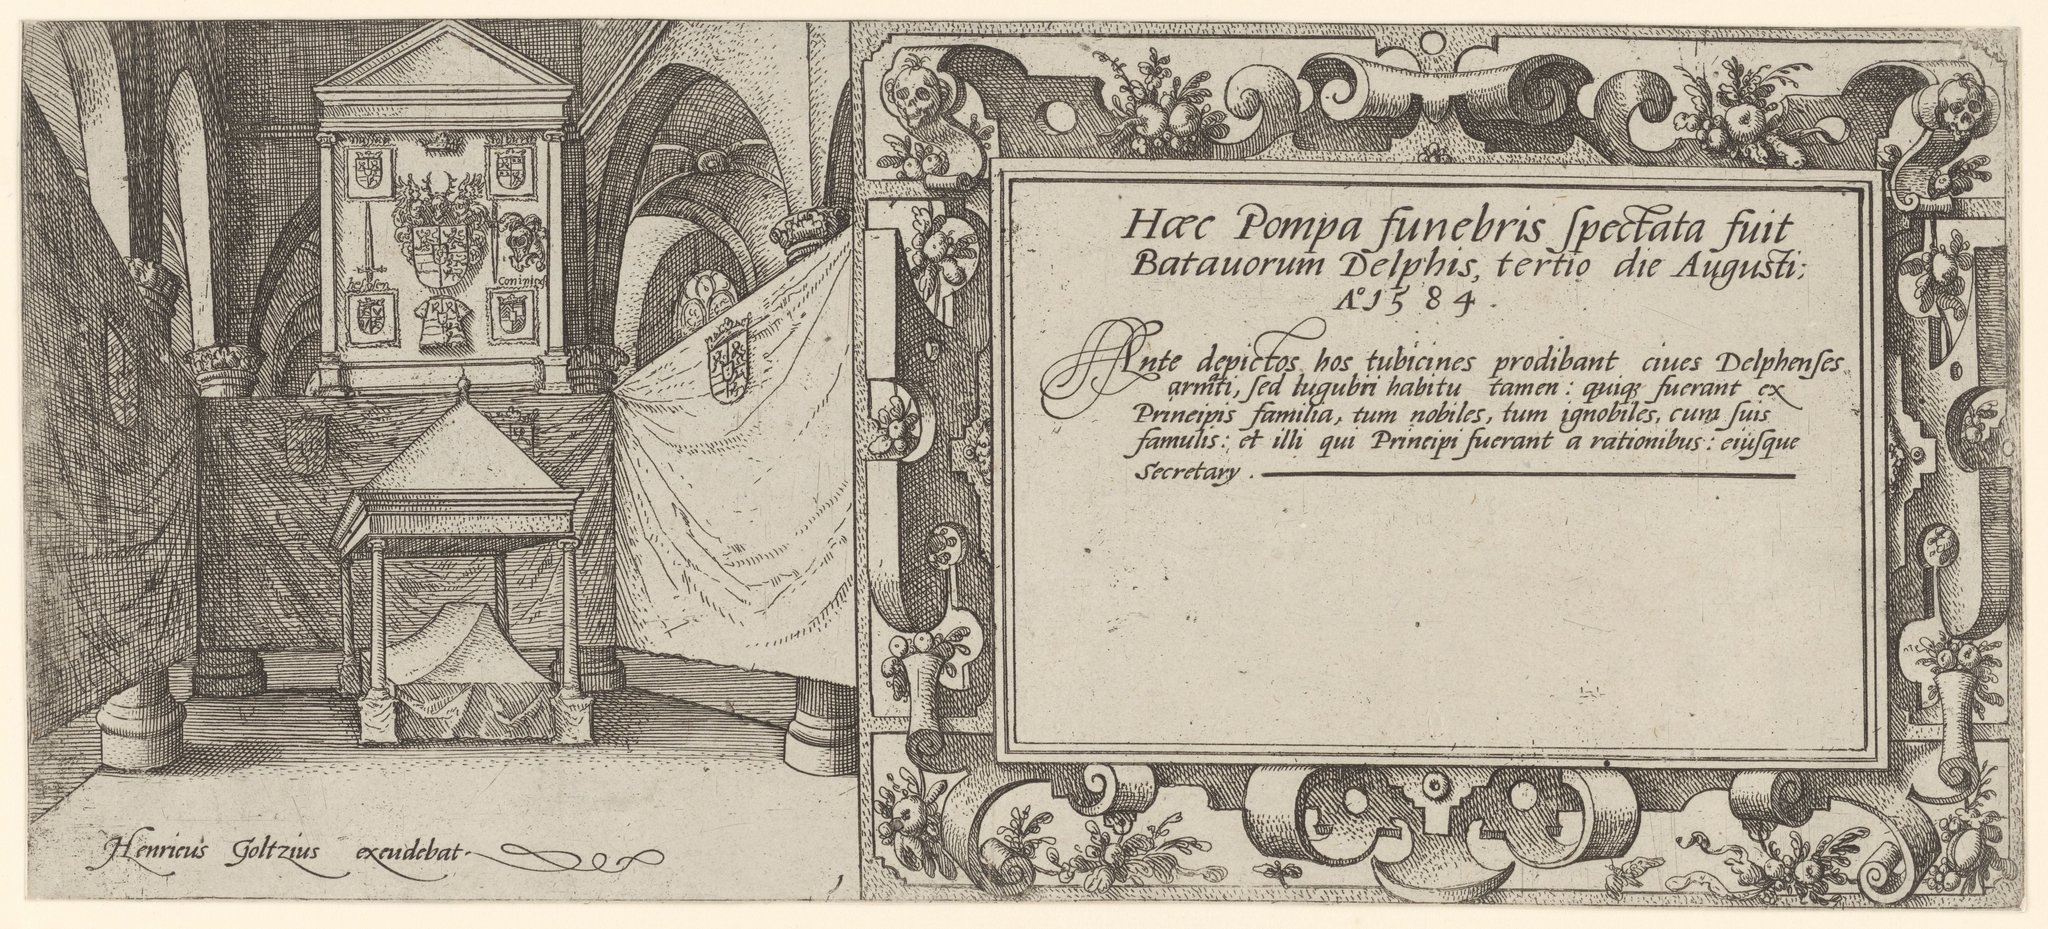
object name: print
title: Haec Pompa funebris spectata fuit Batavorum Delphis, tertio die Augusti; Ao. 1584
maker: hendrick goltzius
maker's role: draughtsman, painter, print maker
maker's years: 1558-1617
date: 1584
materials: paper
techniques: engraving, etching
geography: haarlem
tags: delft, william i (prince of orange), cortege, funeral procession, catafalque, 'castrum doloris' (~ public funeral)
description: Titelprent voor de serie van de begrafenisstoet van Willem van Oranje. Links de katafalk met de lijkkist in de Nieuwe Kerk, rechts de titel in gedecoreerde omlijsting. Blad 1 in de begrafenisstoet van Willem van Oranje, Delft 3 augustus 1584.